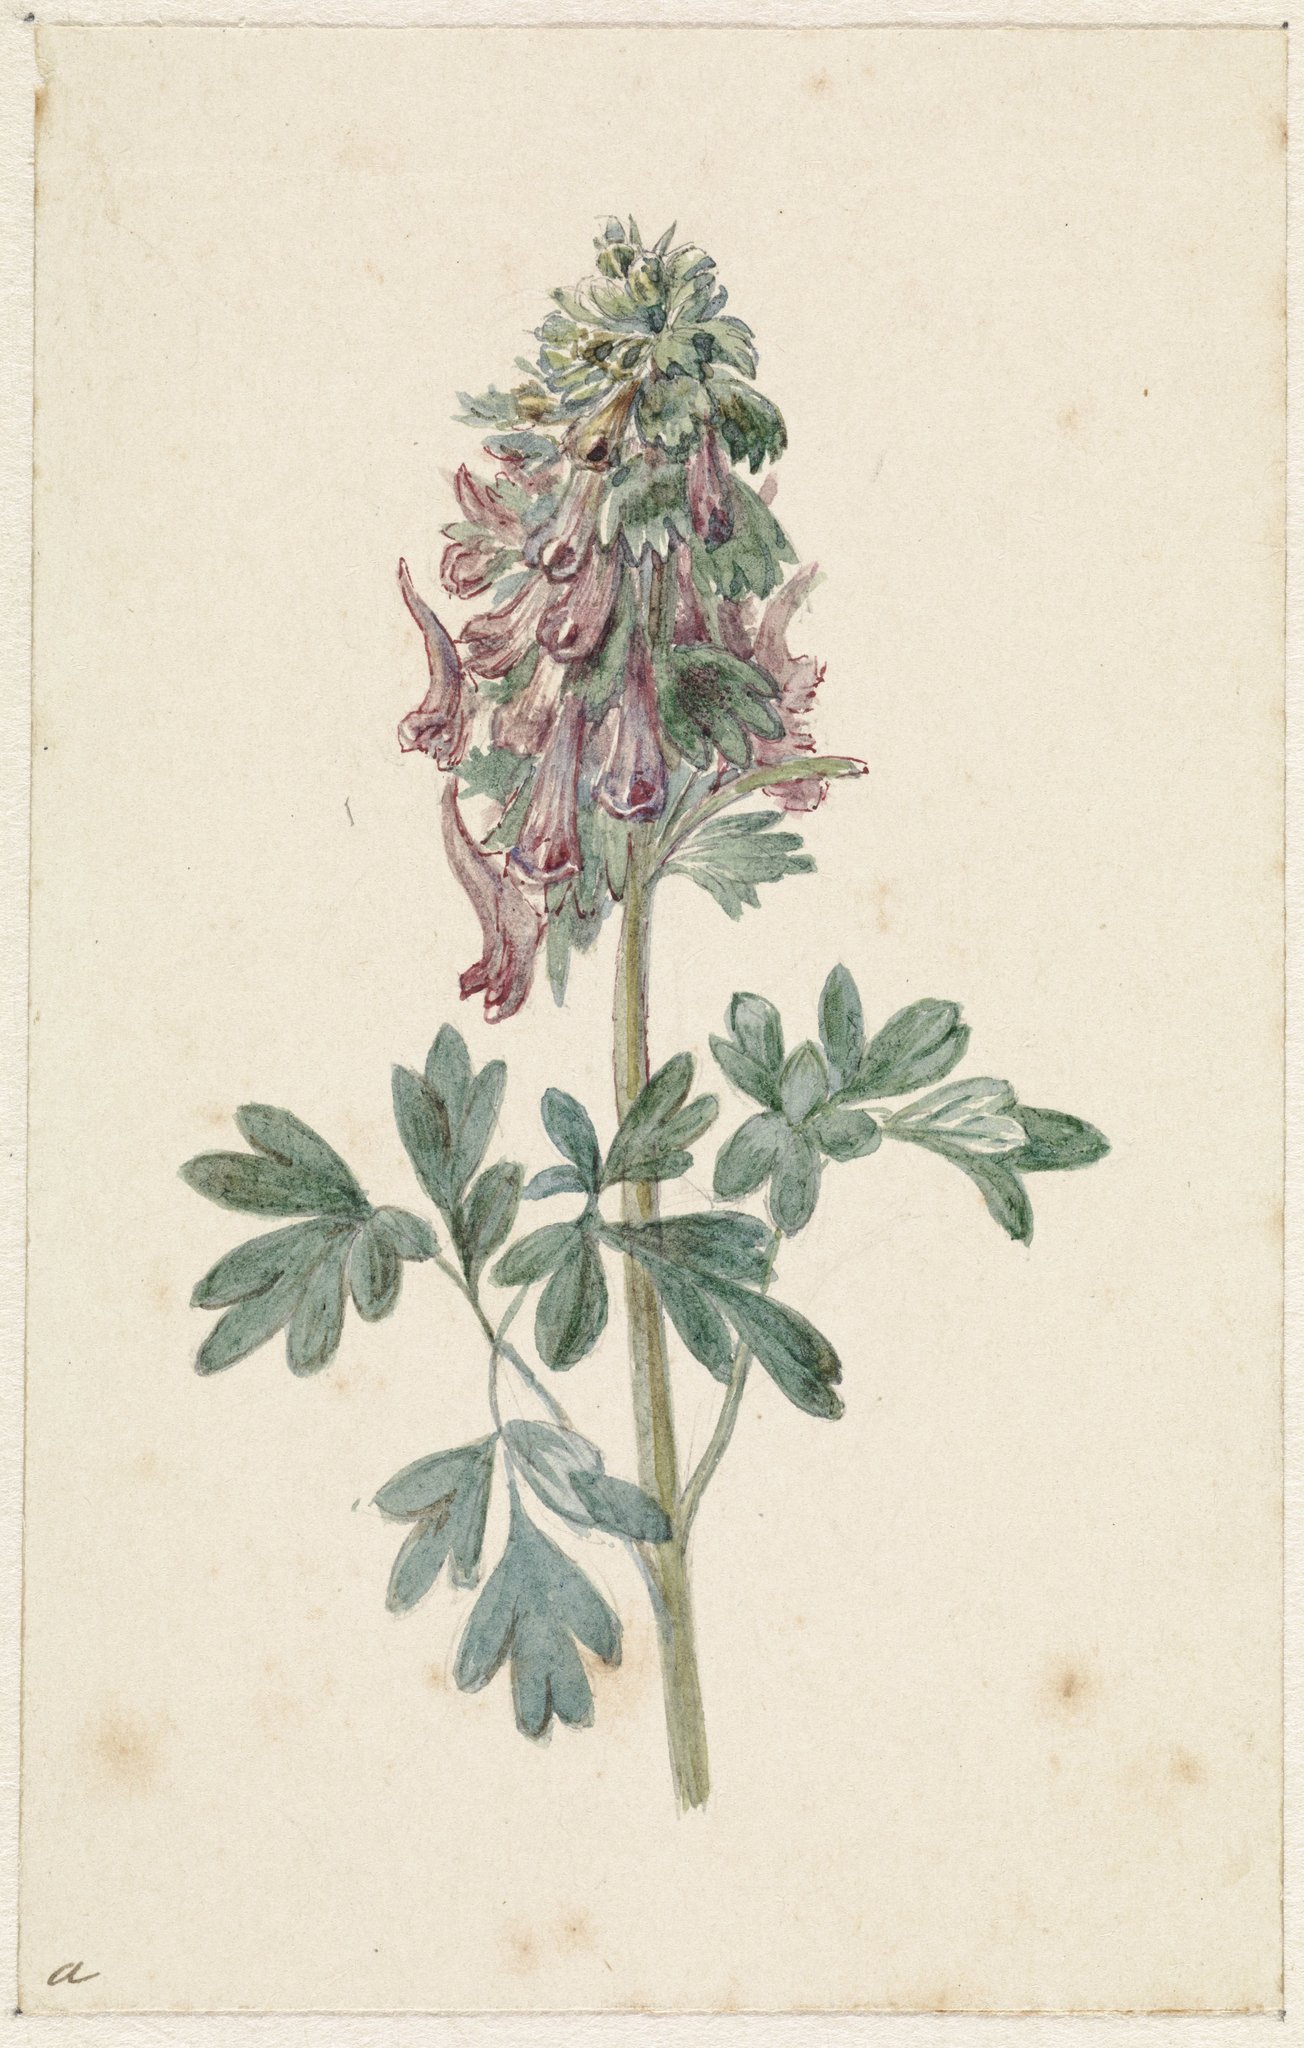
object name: watercolor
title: Bloeiende Corydalis bulbosa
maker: jan jacob goteling vinnis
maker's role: draughtsman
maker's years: 1821-1900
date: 1831-1900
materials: ink, paper, pencil, watercolor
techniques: brush, pen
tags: flowers: corydalis